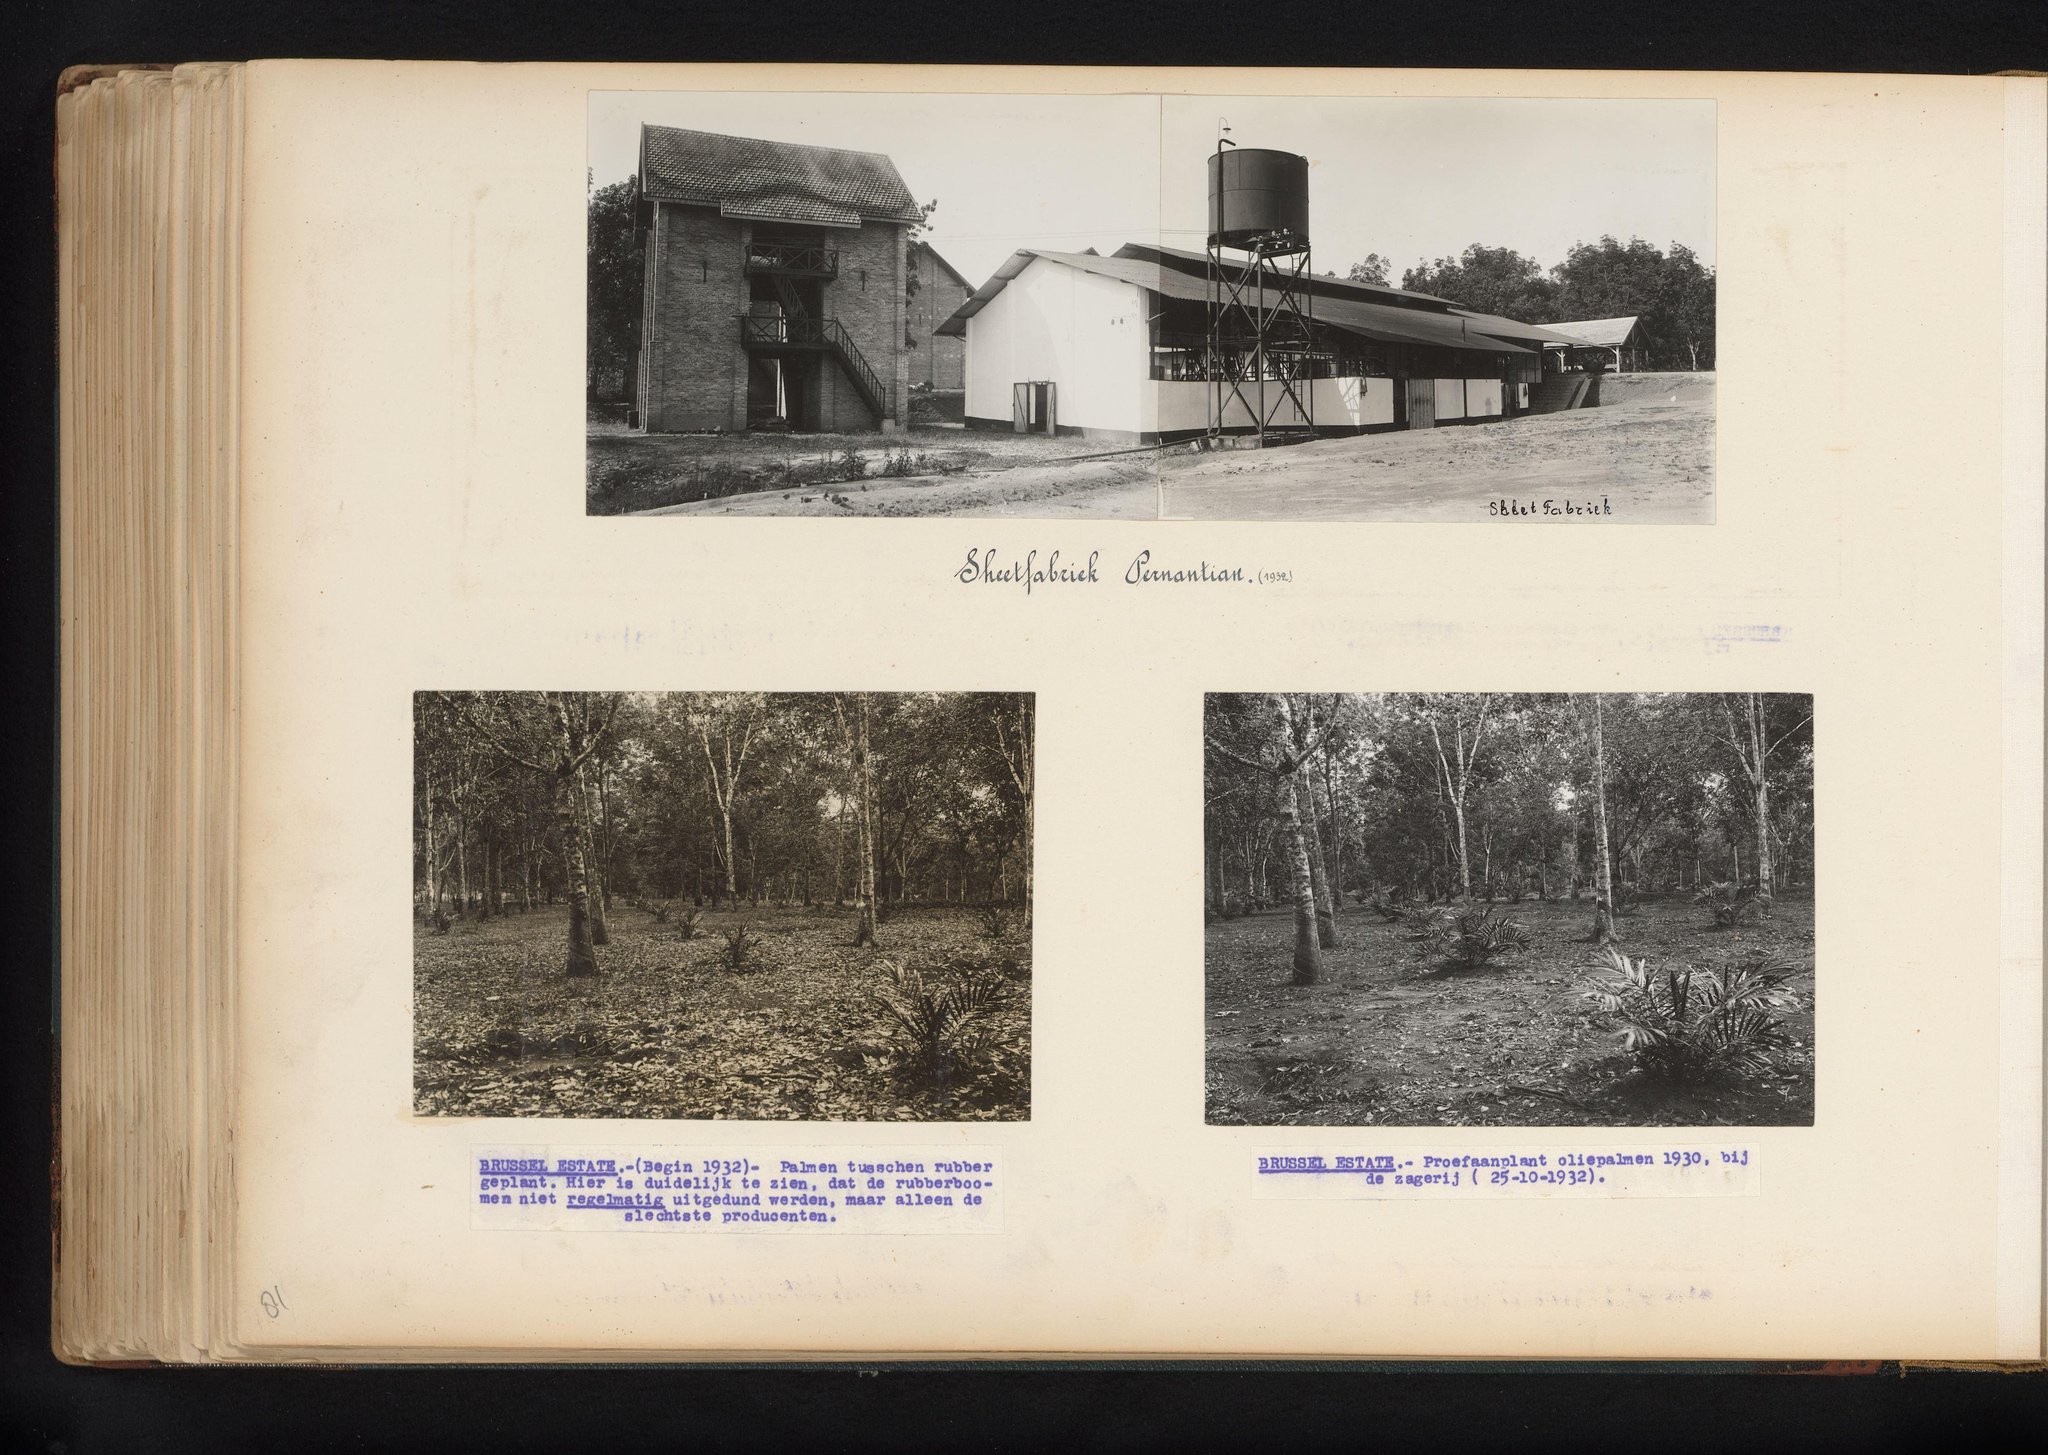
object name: album leaf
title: Pernantian en Brussel, 1932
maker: Anonymous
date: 1932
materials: cardboard, photographic support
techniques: gelatin silver print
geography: sumatra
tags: plantation, (non-fruit) products of plants or trees: rubber, (non-fruit) products of plants or trees: palm oil, exterior of industrial structures, factories, sumatra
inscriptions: inscription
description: Blad met een foto van de zgn. 'sheetfabriek' op rubberproductie op Pernantian en twee foto's van de aanplant van oliepalmen tussen rubberbomen op Brussel, 1932. Met etiketten met onderschriften onder de foto's. Onderdeel van het fotoalbum over de plantages Brussel en Pernantian van de Sumatra Caoutchouc Maatschappij op de Oostkust van Sumatra in de jaren 1910-1935.